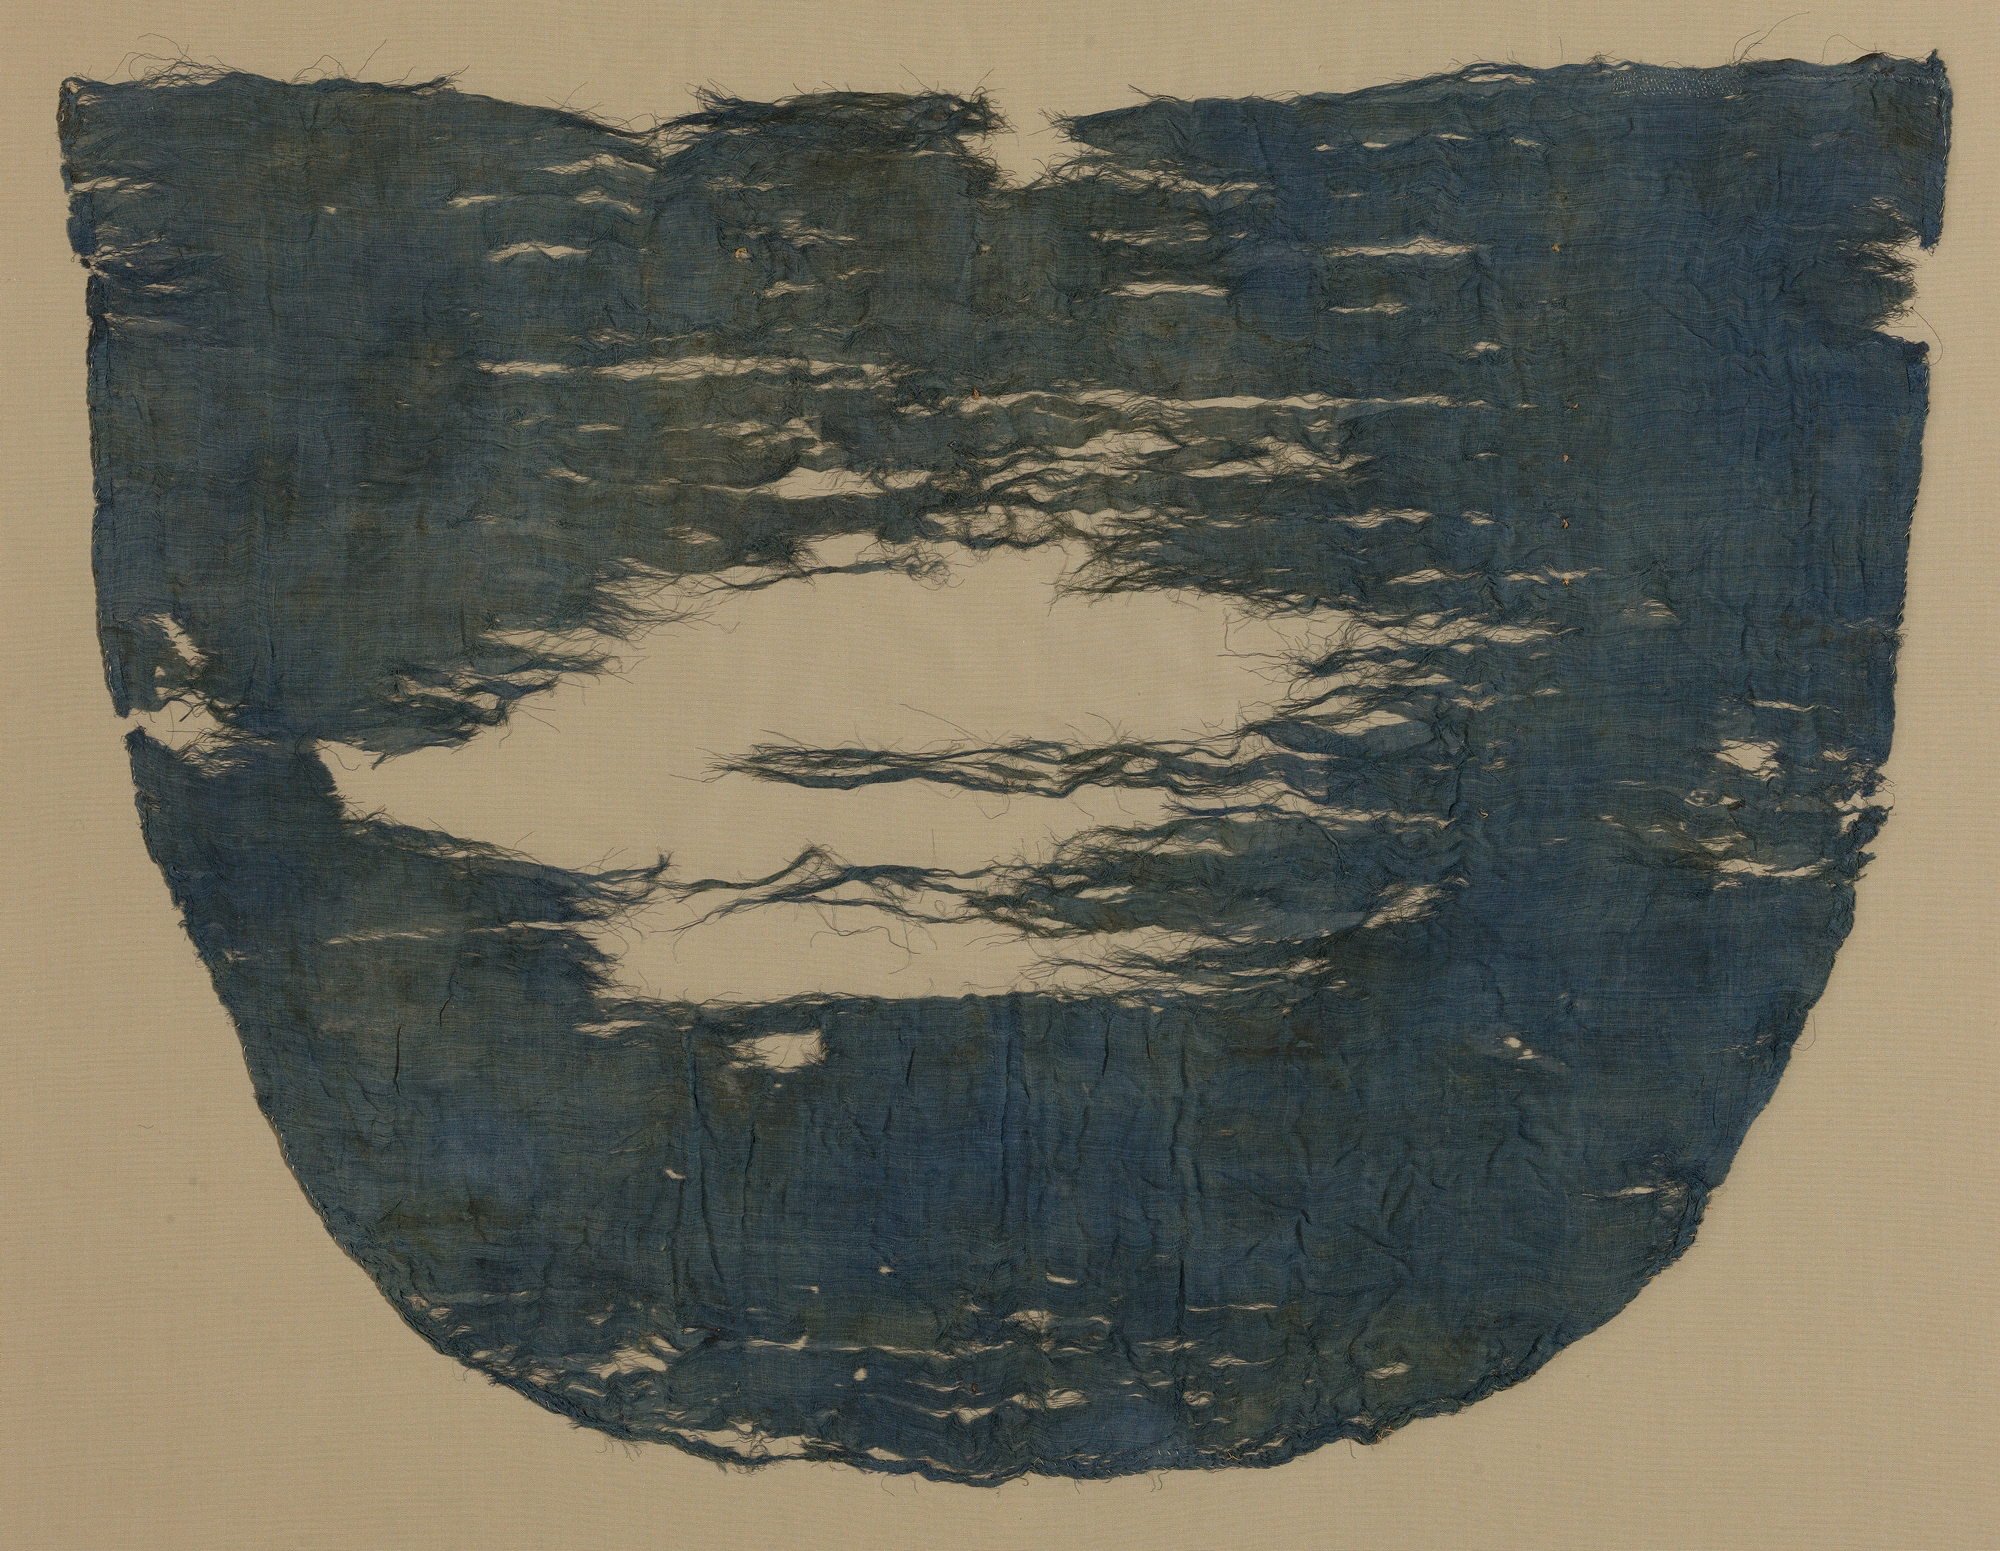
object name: kerchief, indigotin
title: Blue Kerchief from Tutankhamun's Embalming Cache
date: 1336-1327 BCE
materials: linen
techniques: dyeing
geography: egypt